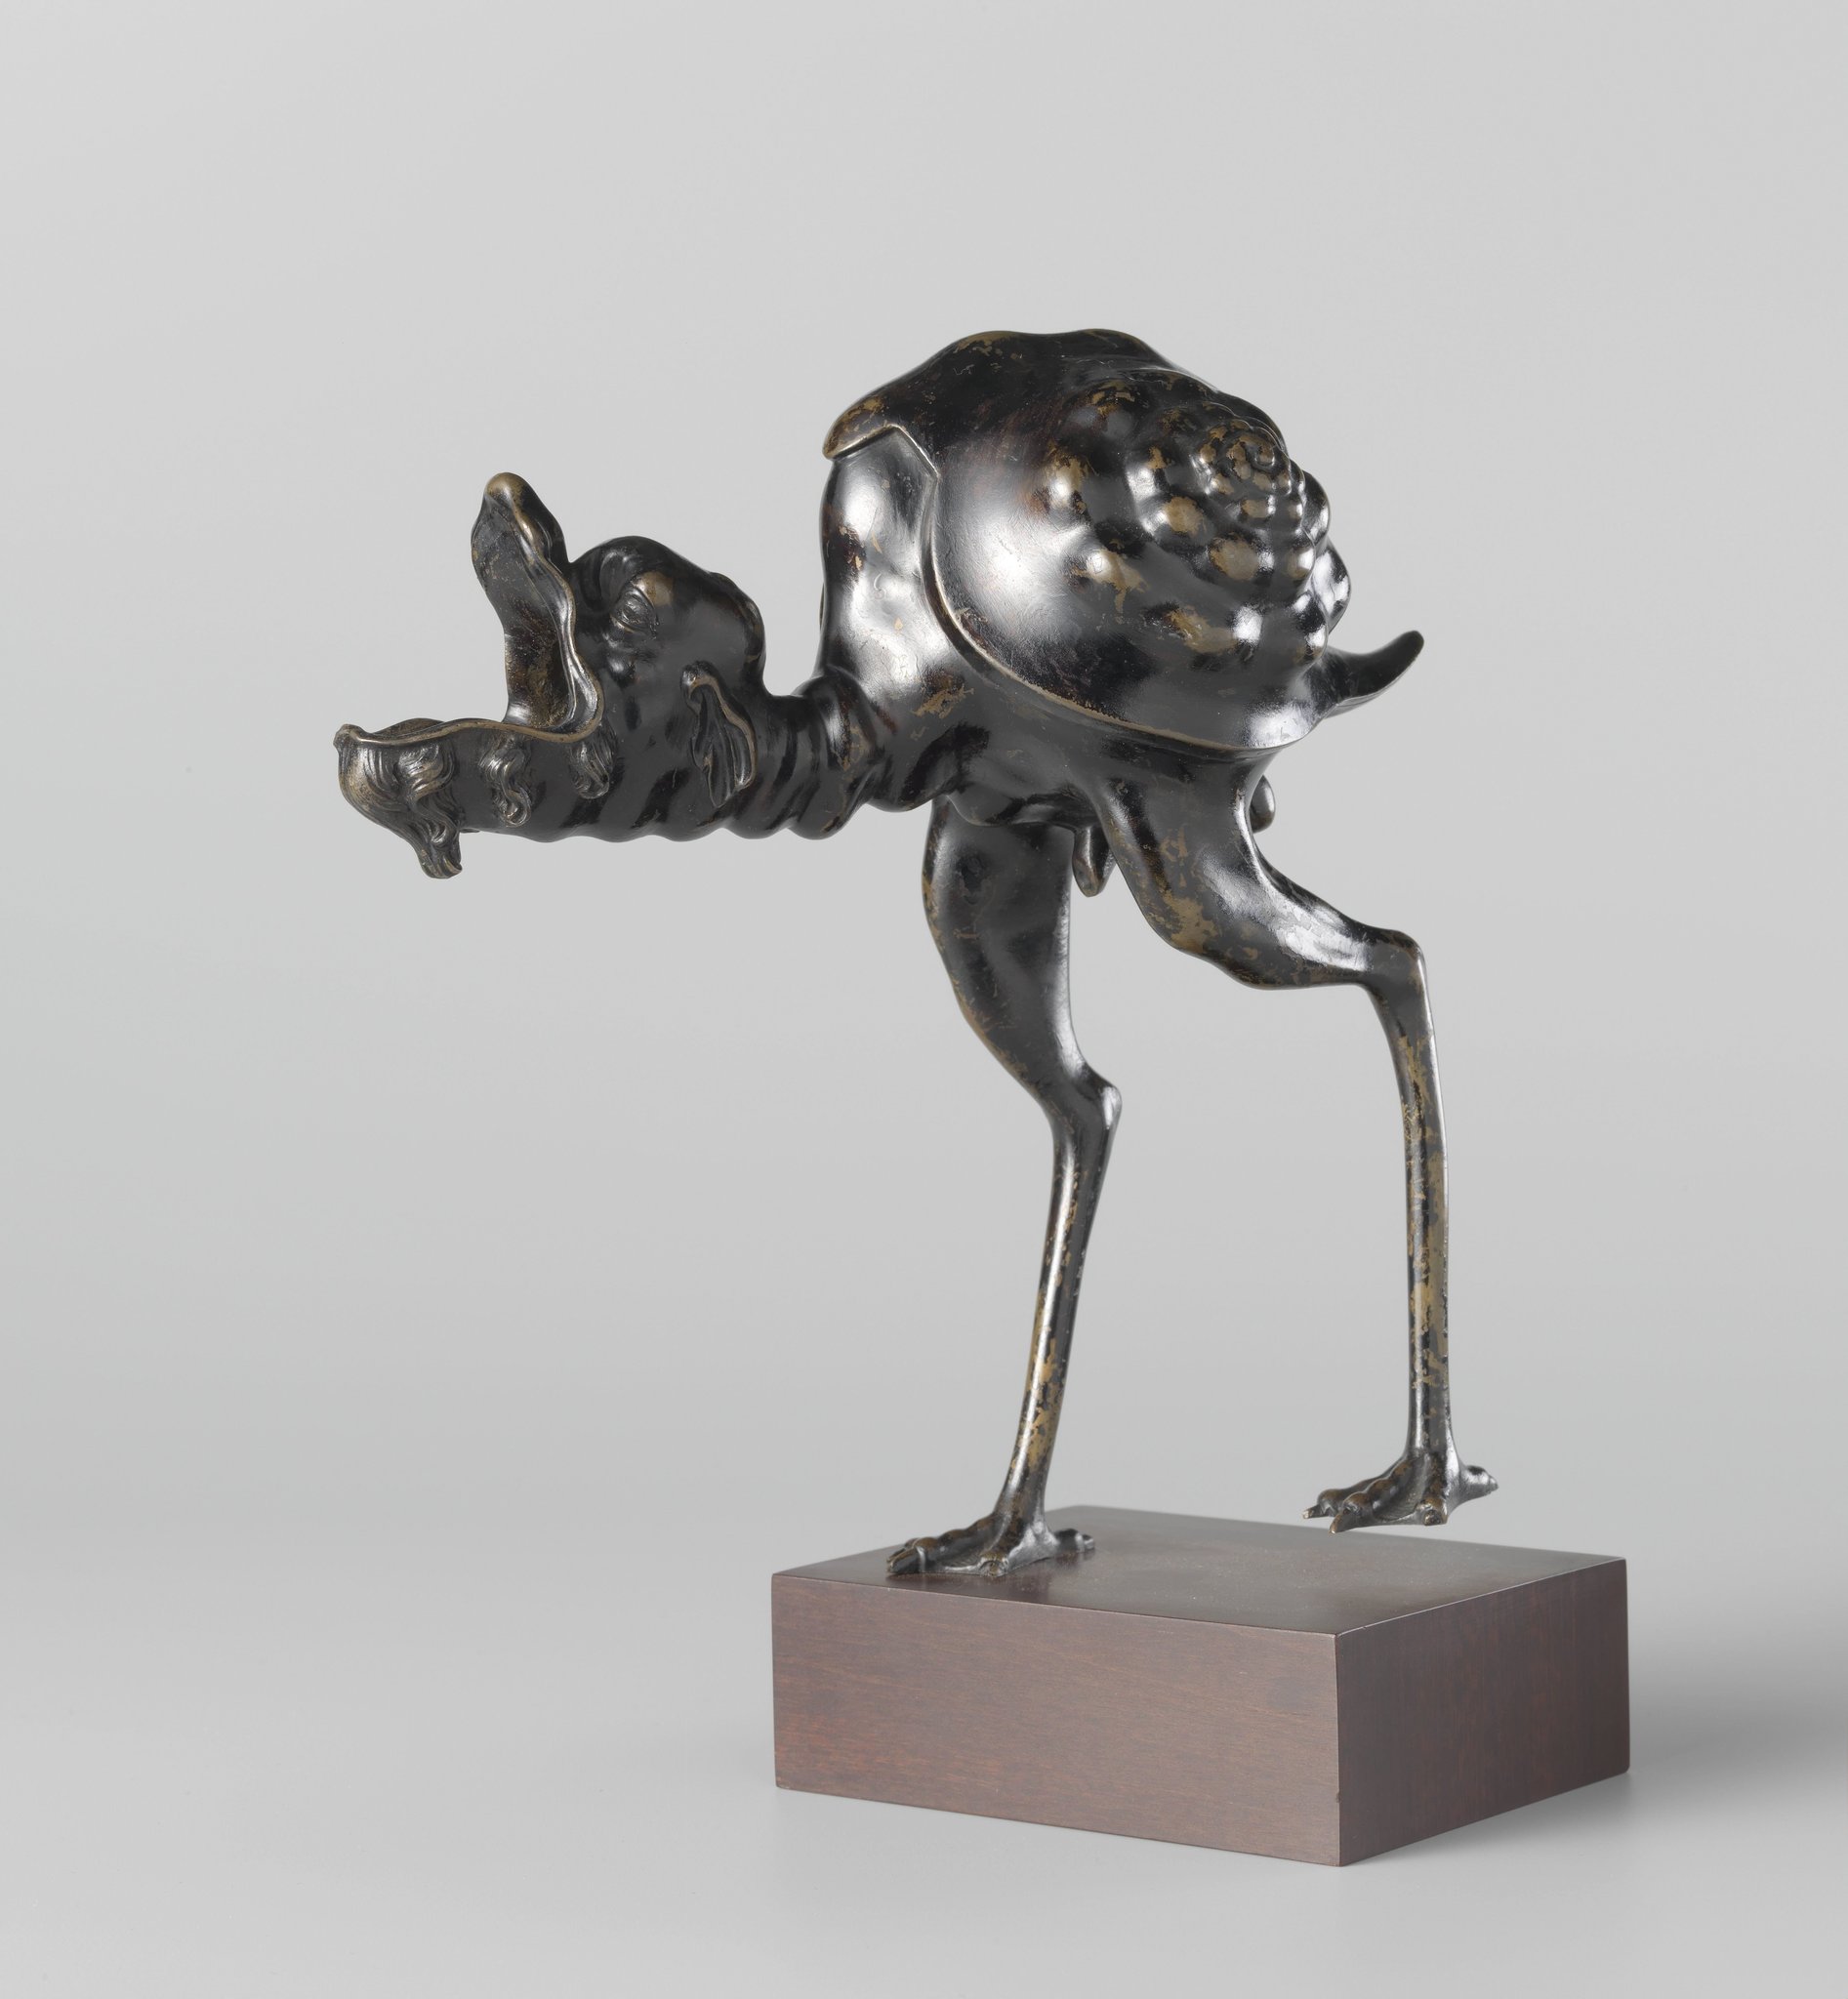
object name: figure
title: Grotesque Animal, Oil Lamp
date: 1780-1900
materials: bronze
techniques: lacquer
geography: rome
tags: fabulous animals ~ birds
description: The body of a snail, the legs of an ostrich, a head that is birdlike yet human: the silversmith Arent van Bolten was fascinated by such bizarre monsters, as is evidenced by his numerous design drawings and prints. This statuette may have once served as an incense burner or an oil lamp.